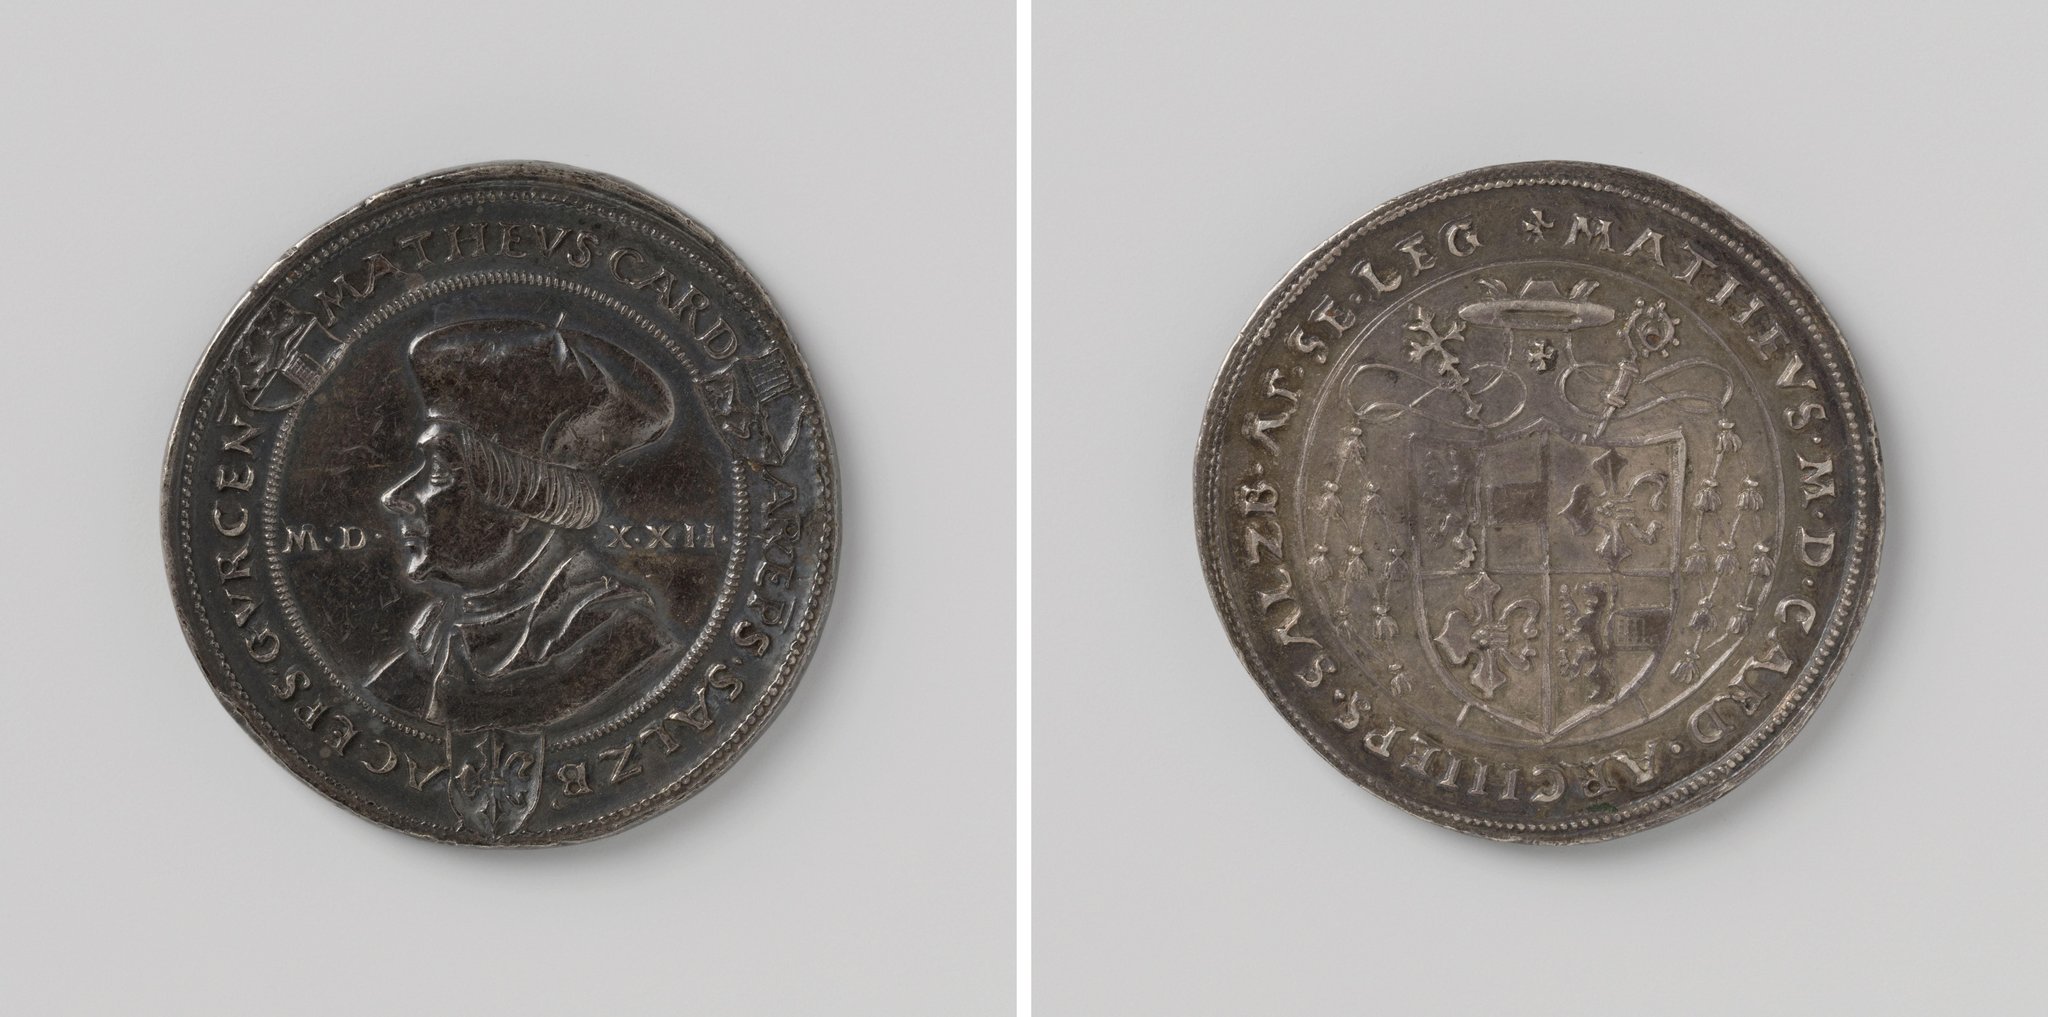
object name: guldiner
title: Taler (guldiner) van kardinaal Matthaeus Lang van Wellenburg, aartsbisschop van Salzburg en bisschop van Gurk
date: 1522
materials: silver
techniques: striking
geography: salzburg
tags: augsburg, matthäus lang von wellenburg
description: Voorzijde: borststuk man met kardinaalsmuts tussen jaartal, binnen omschrift onderbroken door drie wapenschilden. Keerzijde: wapenschild met aartsbisschoppelijk kruis en bischopsstaf onder kardinaalshoed binnen omschrift